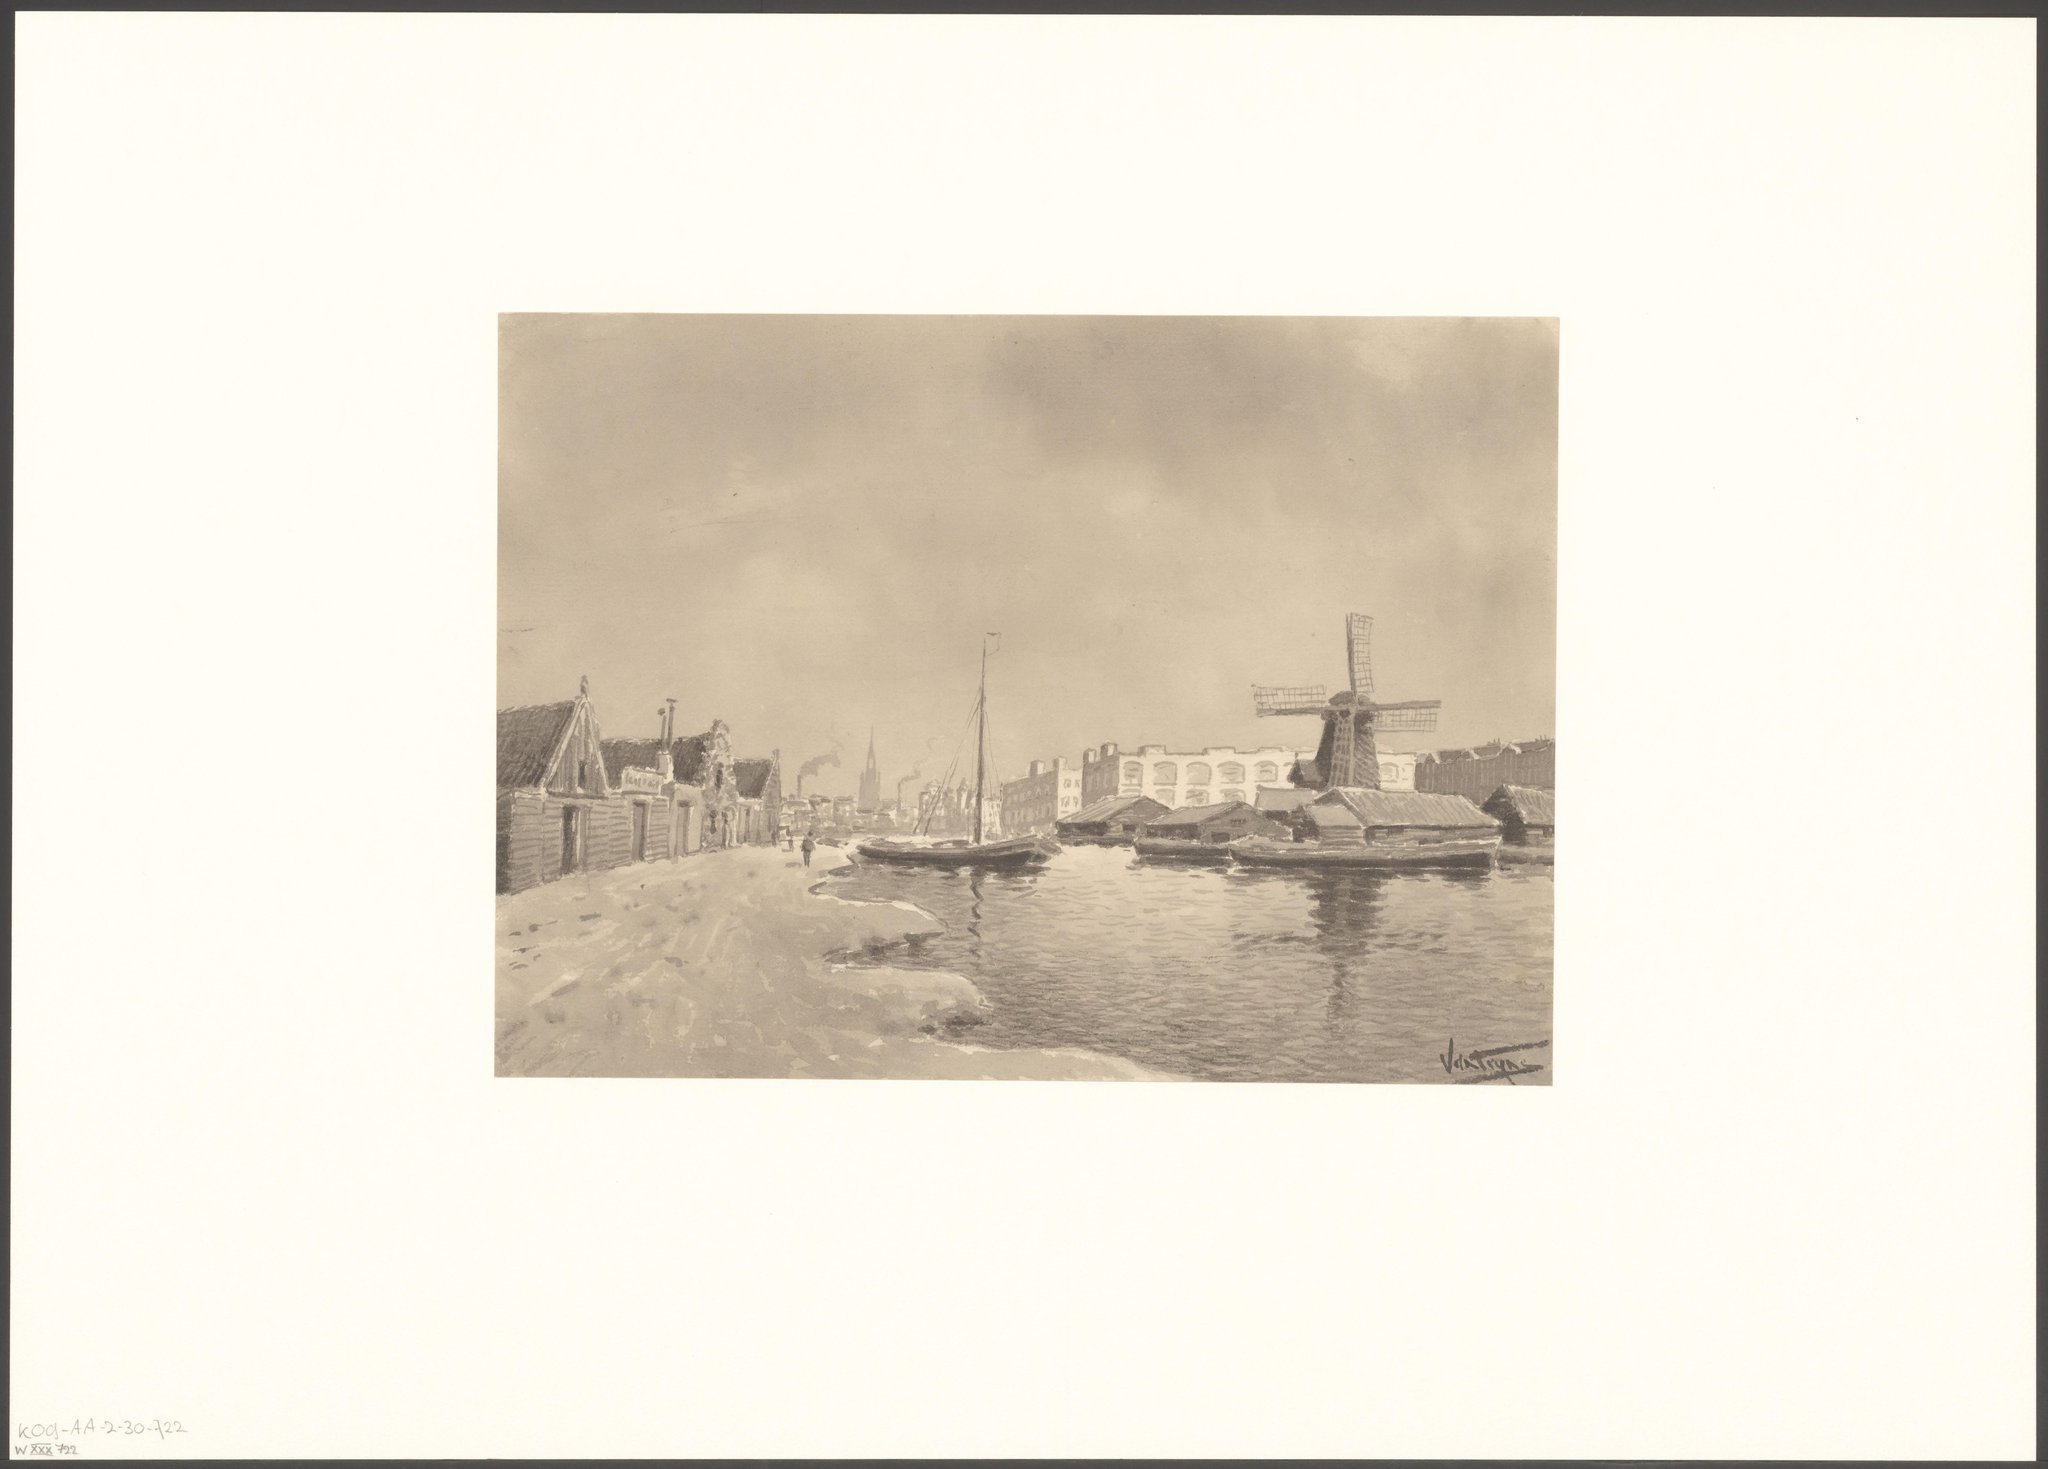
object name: drawing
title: Gezicht op de Kostverlorenvaart en de Buyskade met molen Het Luipaard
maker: anthonie van teijn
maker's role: draughtsman, painter, print maker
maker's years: 1863-1943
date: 1907-1927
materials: ink, paper, pencil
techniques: brush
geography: amsterdam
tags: sailing-ship, sailing-boat, city-view in general; 'veduta', canal, windmill in landscape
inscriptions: collector's mark: Lugt 800a, signature: ‘VanTeyne’, inscription: ‘De Kostverlorenvaart aan (...) Juli 1927. / vanEck’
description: Tekening binnen de Atlas Van Eck ingedeeld op wijknummer 30.